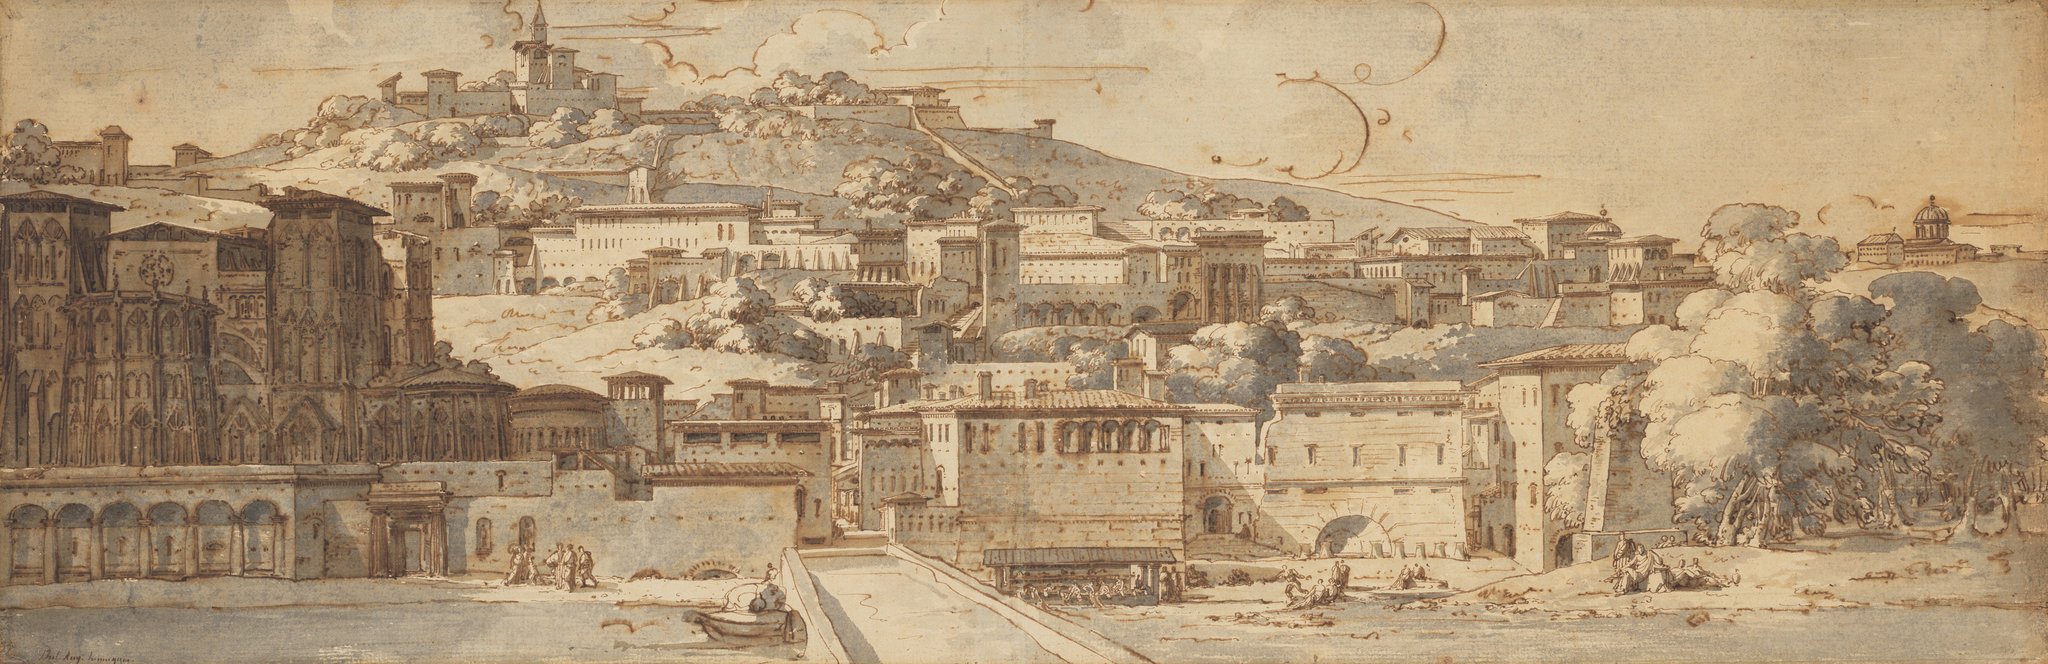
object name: drawing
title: View of Lyon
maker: philippe auguste hennequin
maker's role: artist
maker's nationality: french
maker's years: 1762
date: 1793-1795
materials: chalk, ink, paper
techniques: brush, pen, wash